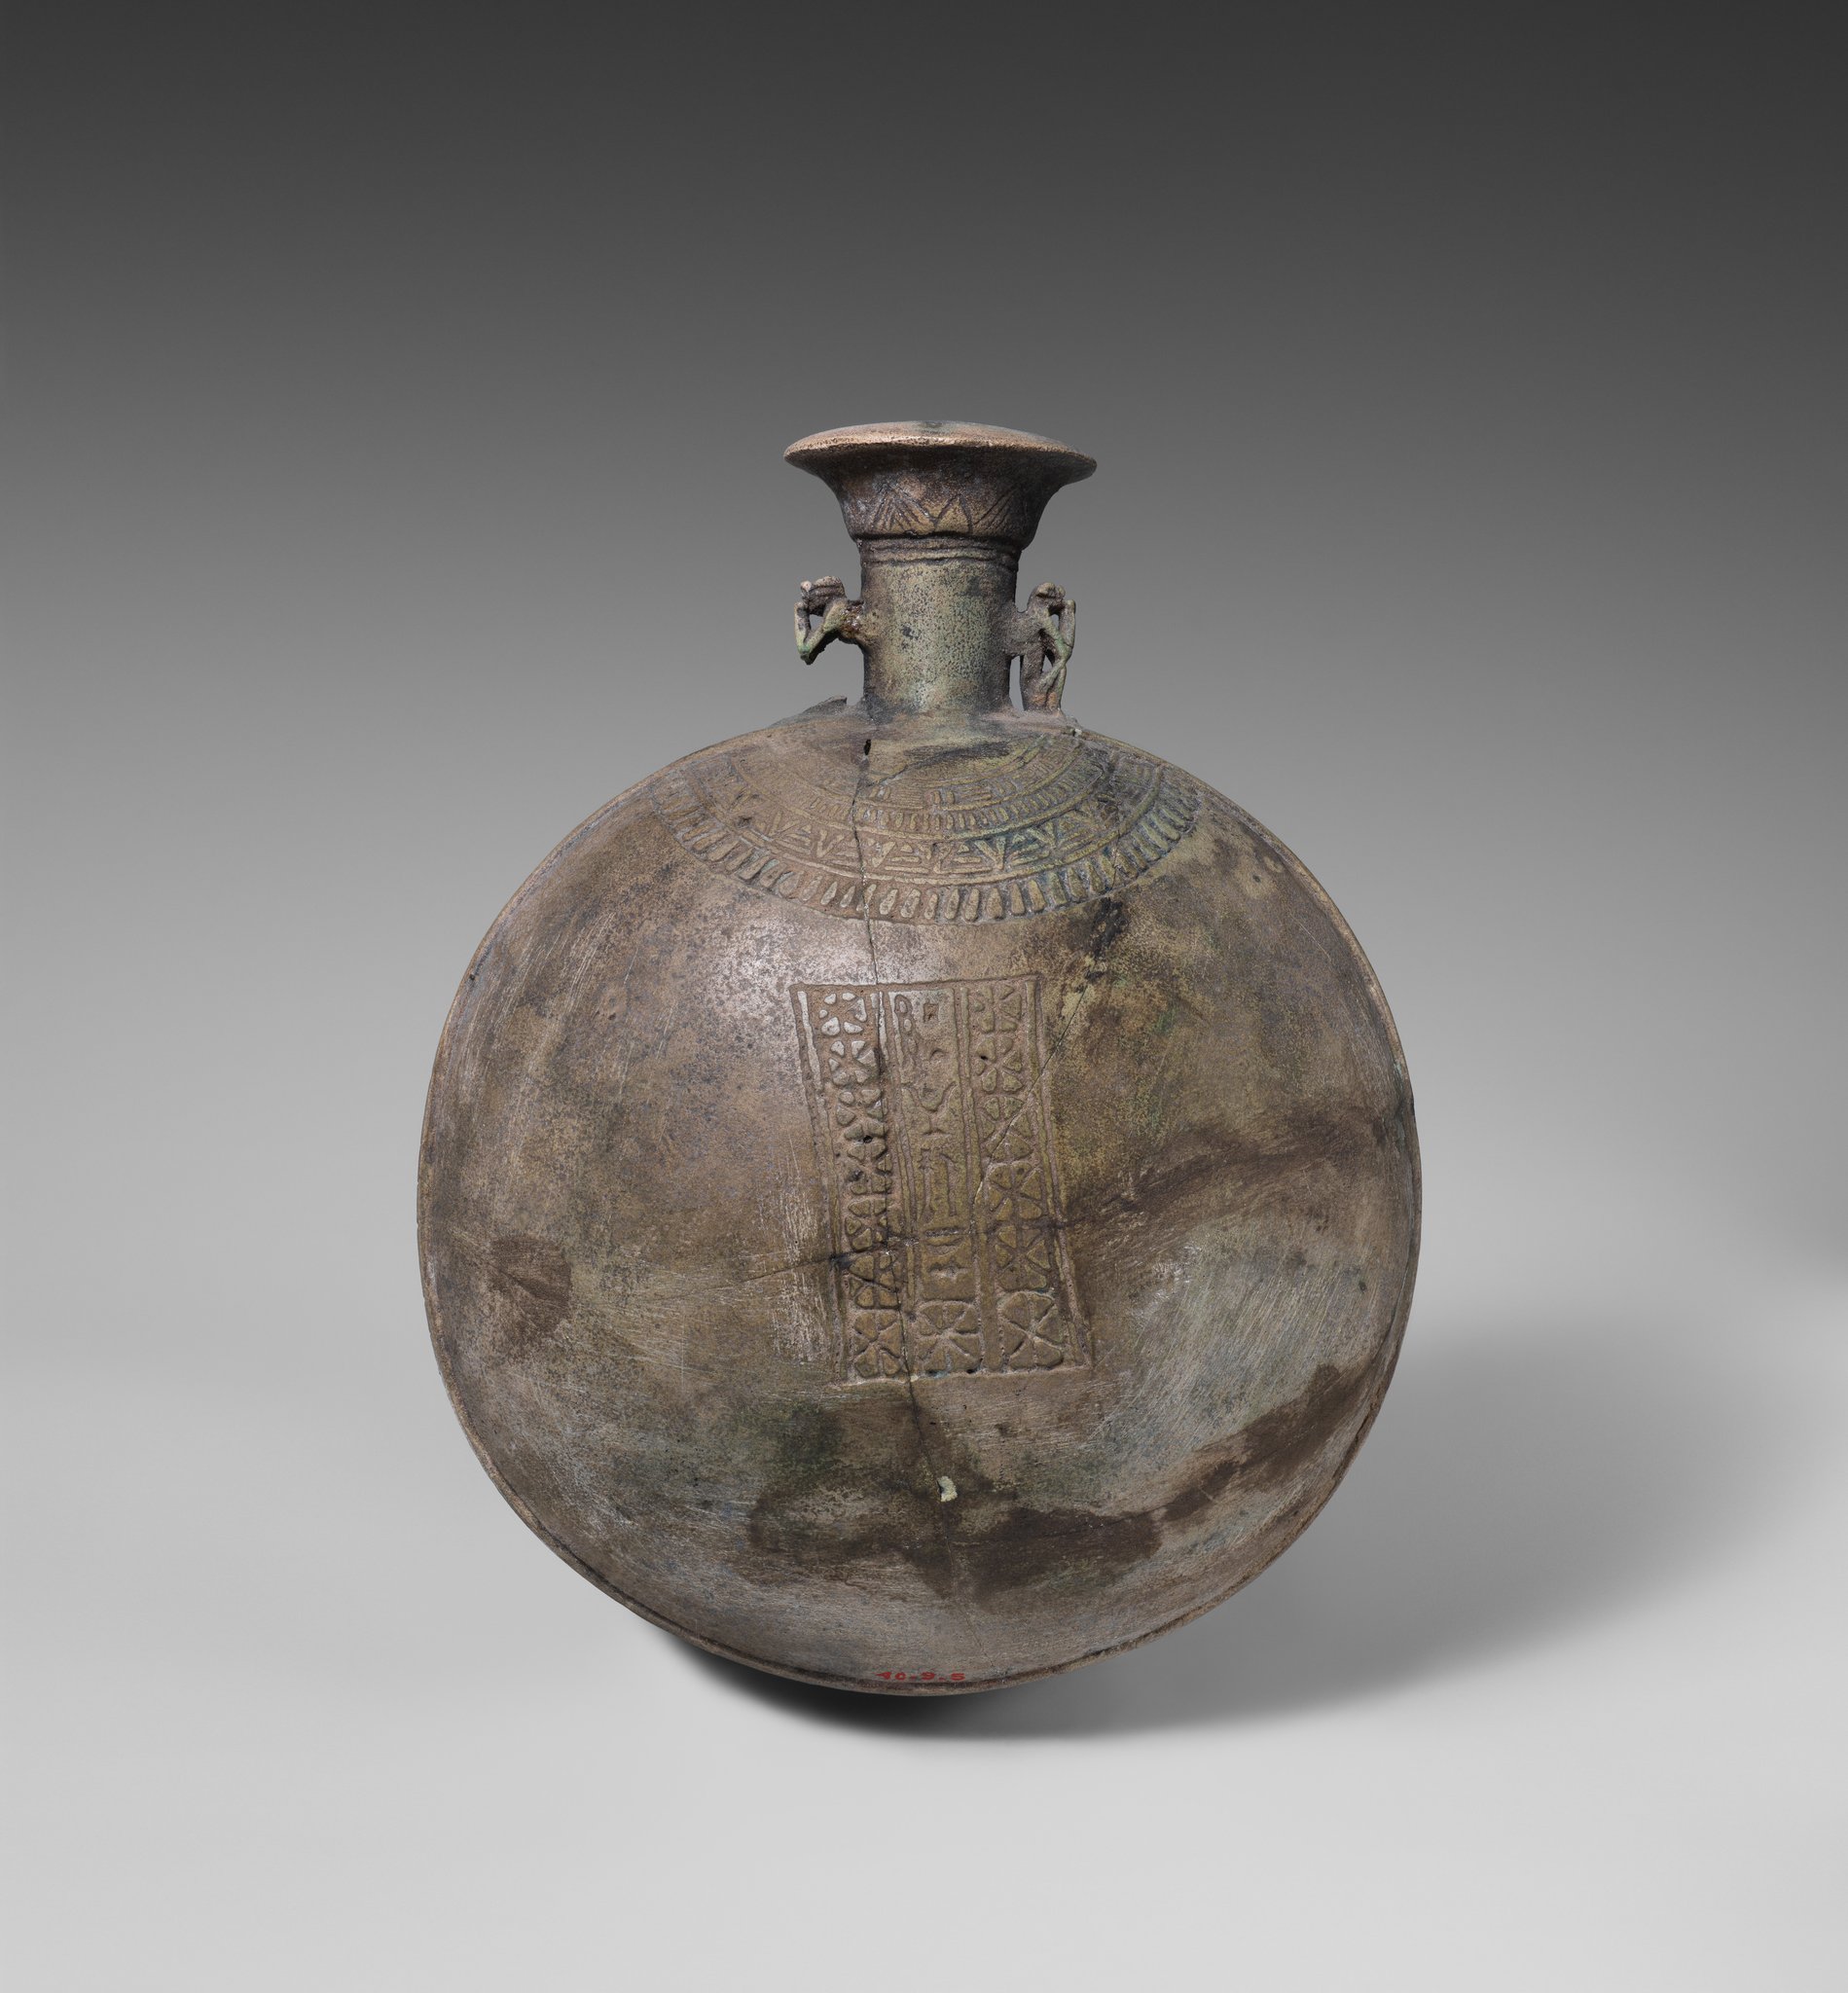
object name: lentoid bottle, new year's bottle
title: Lentoid Bottle ("New Year's Bottle")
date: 664-332 BCE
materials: faience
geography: egypt